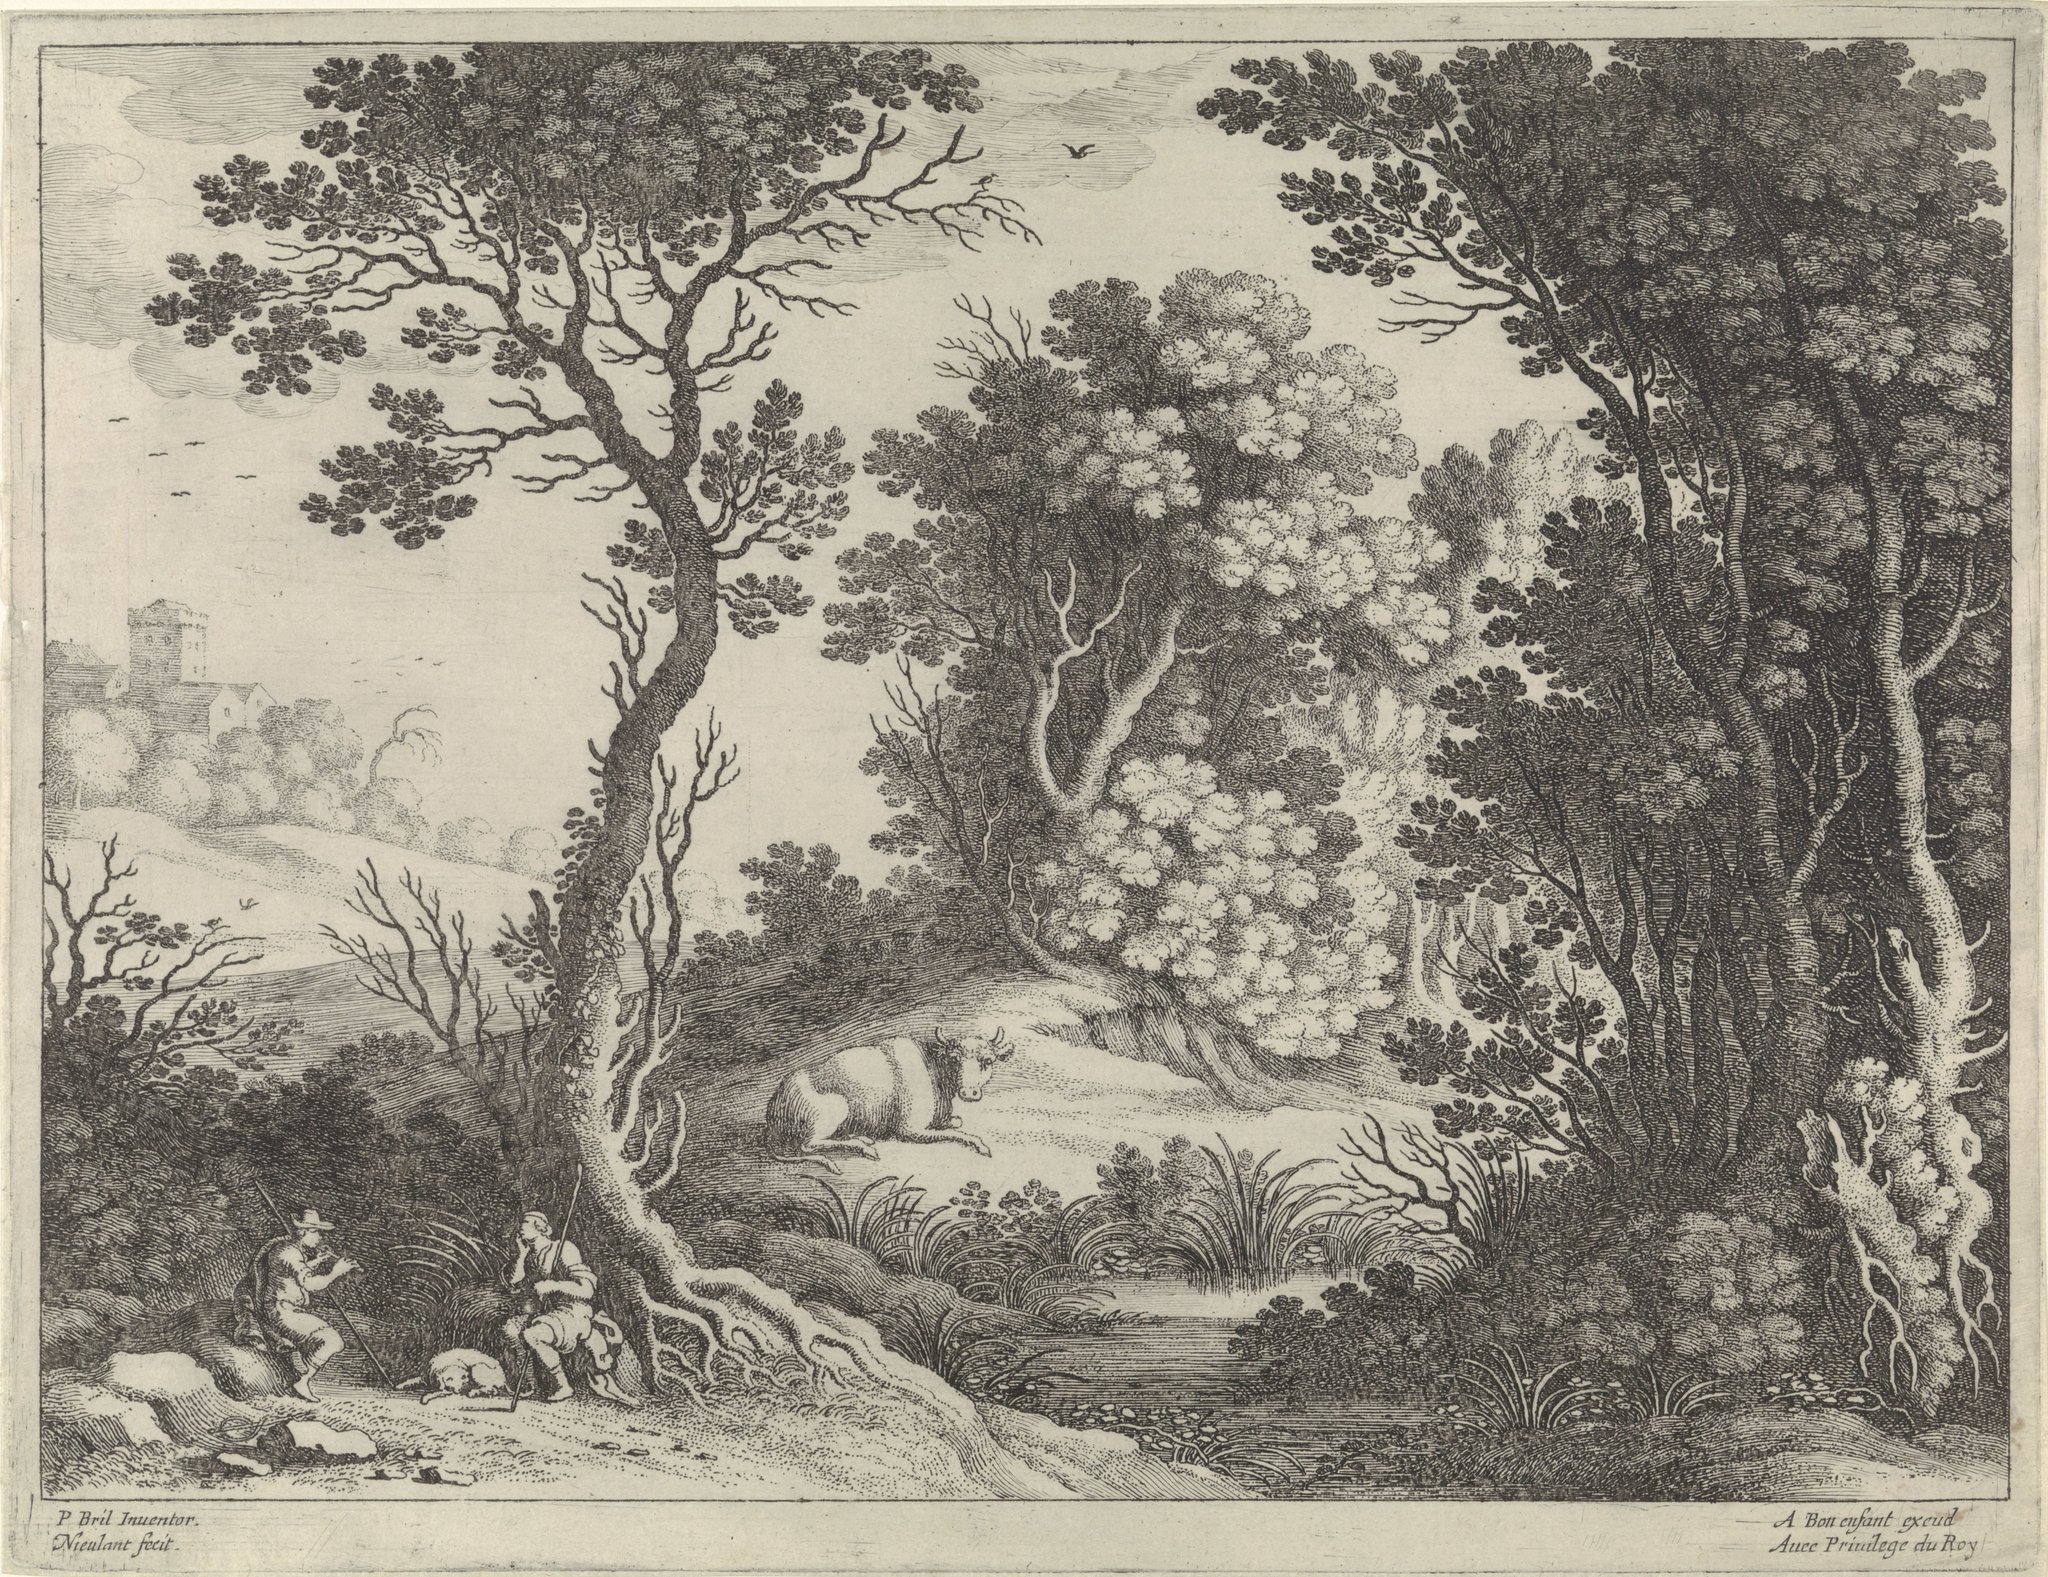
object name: print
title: Mercurius, Argus en Io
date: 1594-1635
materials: paper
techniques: engraving, etching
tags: trees, mercury lulls argus into sleep by making music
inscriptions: collector's mark: Lugt 240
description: Mercurius speelt op zijn fluit, zodat Argus, die Io moet bewaken, in slaap valt. De in een koe veranderde Io ligt tussen de bomen.